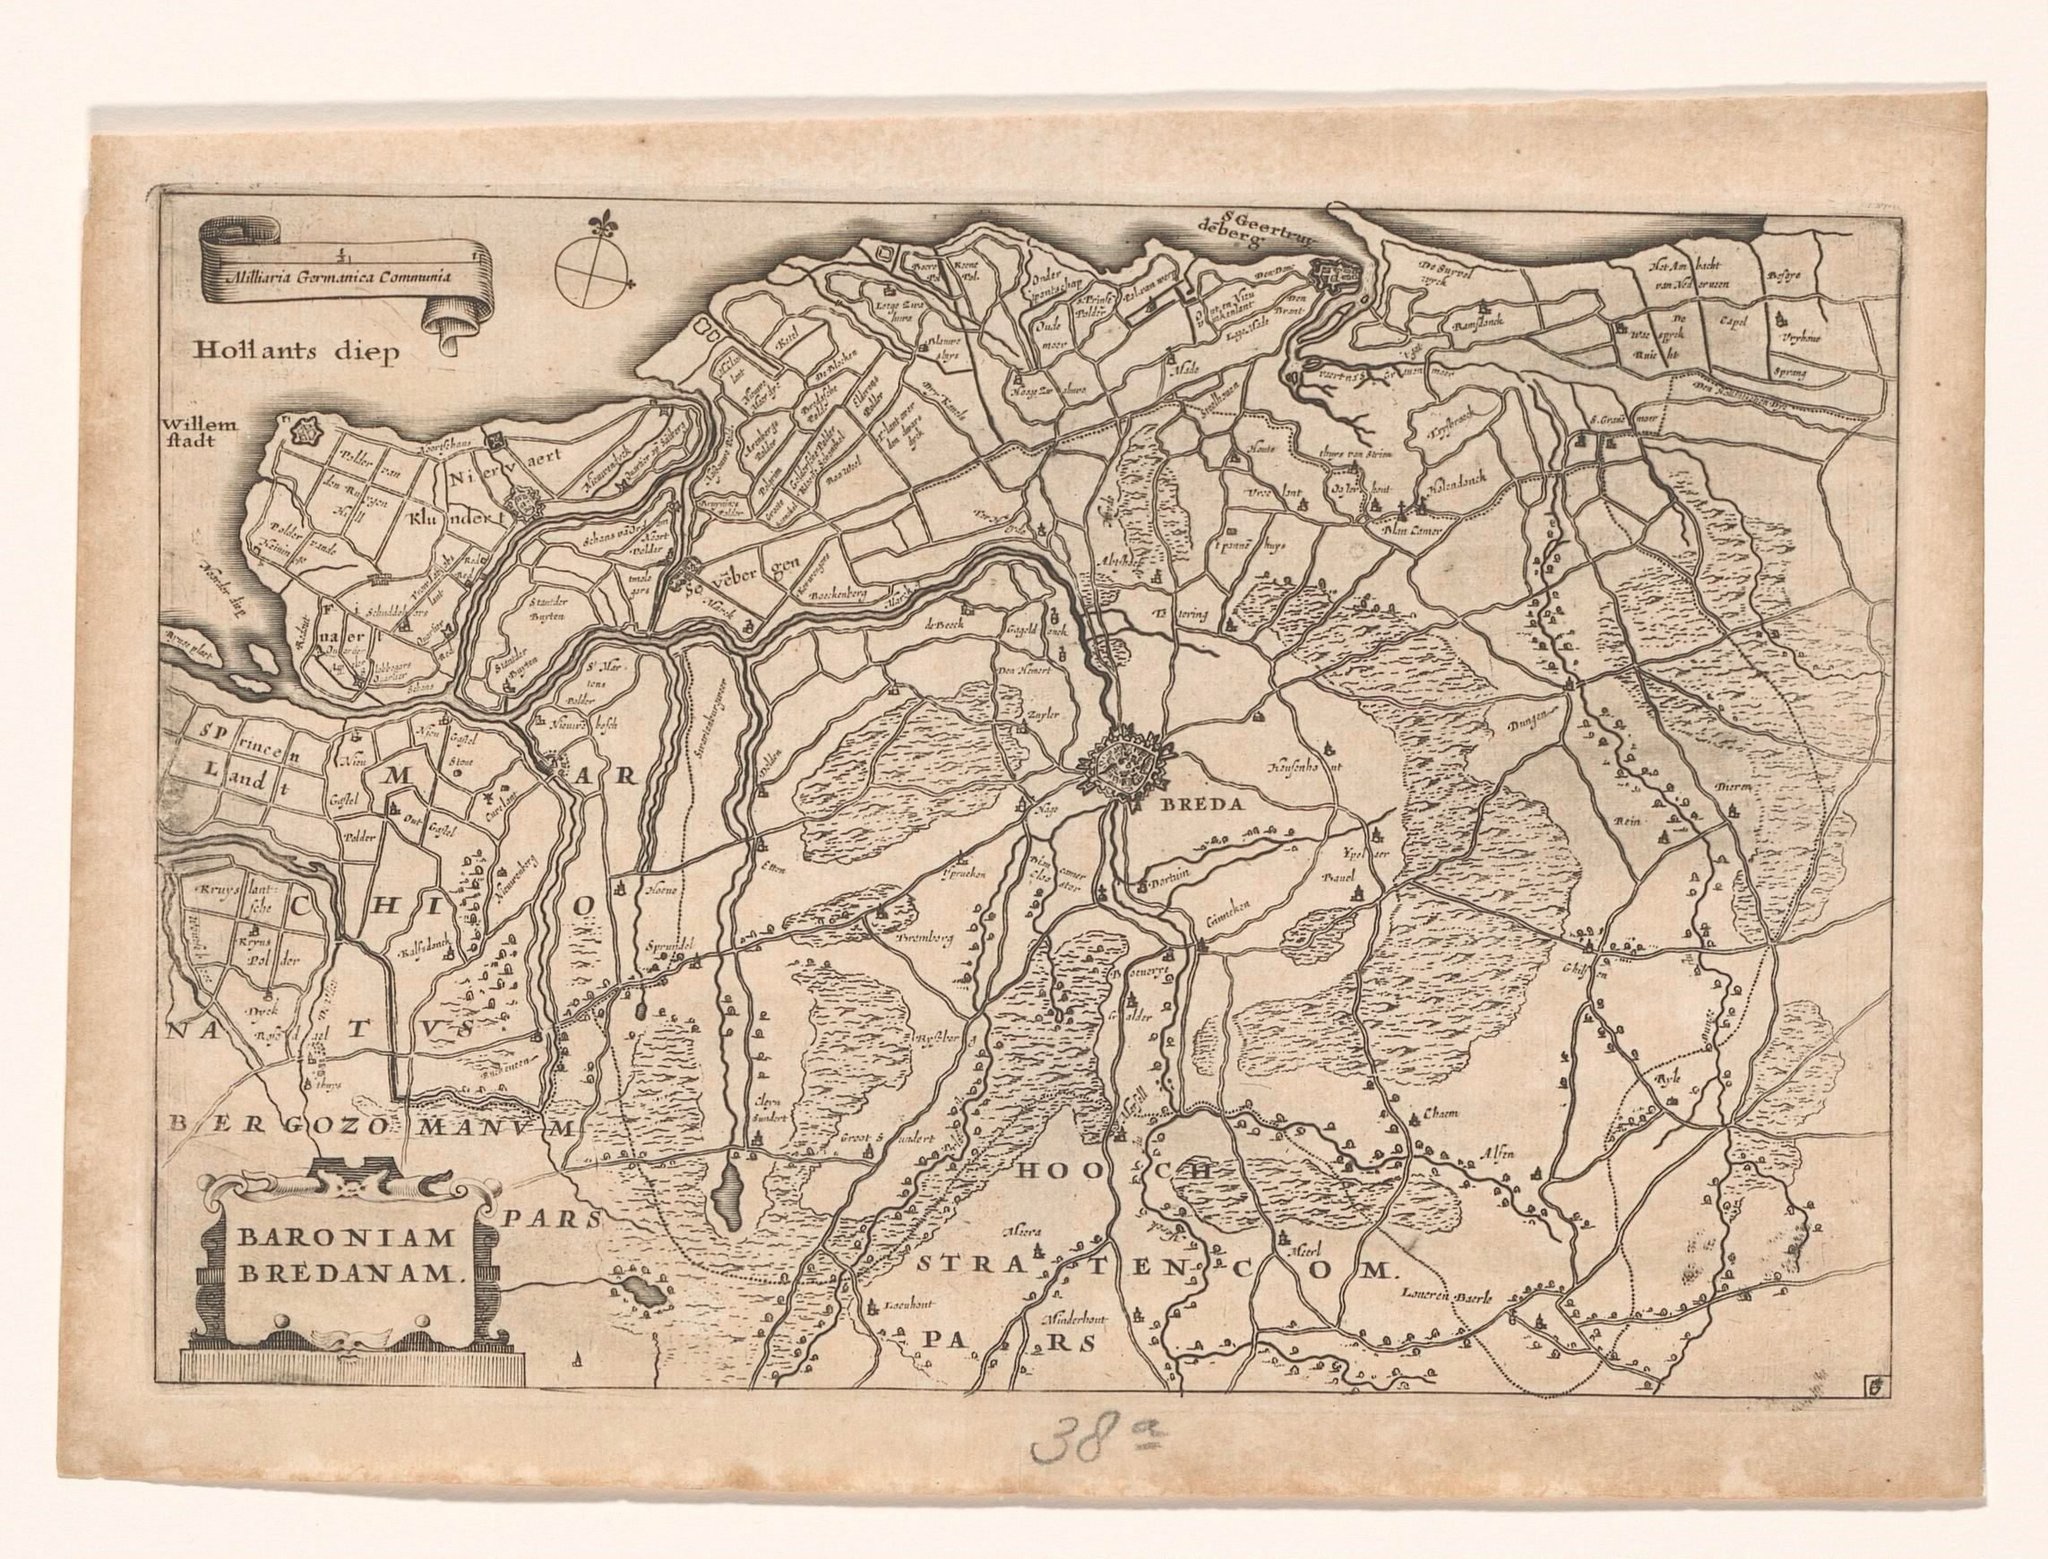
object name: print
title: Baroniam Bredanam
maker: Anonymous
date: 1635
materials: paper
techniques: engraving, etching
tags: maps of separate countries or regions, brabant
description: Deze staat van prent ook gebruikt in: De vyerighe colom klaer vertoonende in vyftich onderscheydene curieuse caarten de XVII. Nederlantsche Provincien (…). Amsterdam: Jacob Aertsz Colom (I), s.a. [ca. 1660]. En in latere uitgaven met de platen van deze publicatie, uitgegeven door Pieter van Alphen (1691) en Pieter van der Slaart (1696). Eerdere staat van prent (zonder '6' rechtsonder) ook gebruikt in eerdere drukken van deze publicatie.